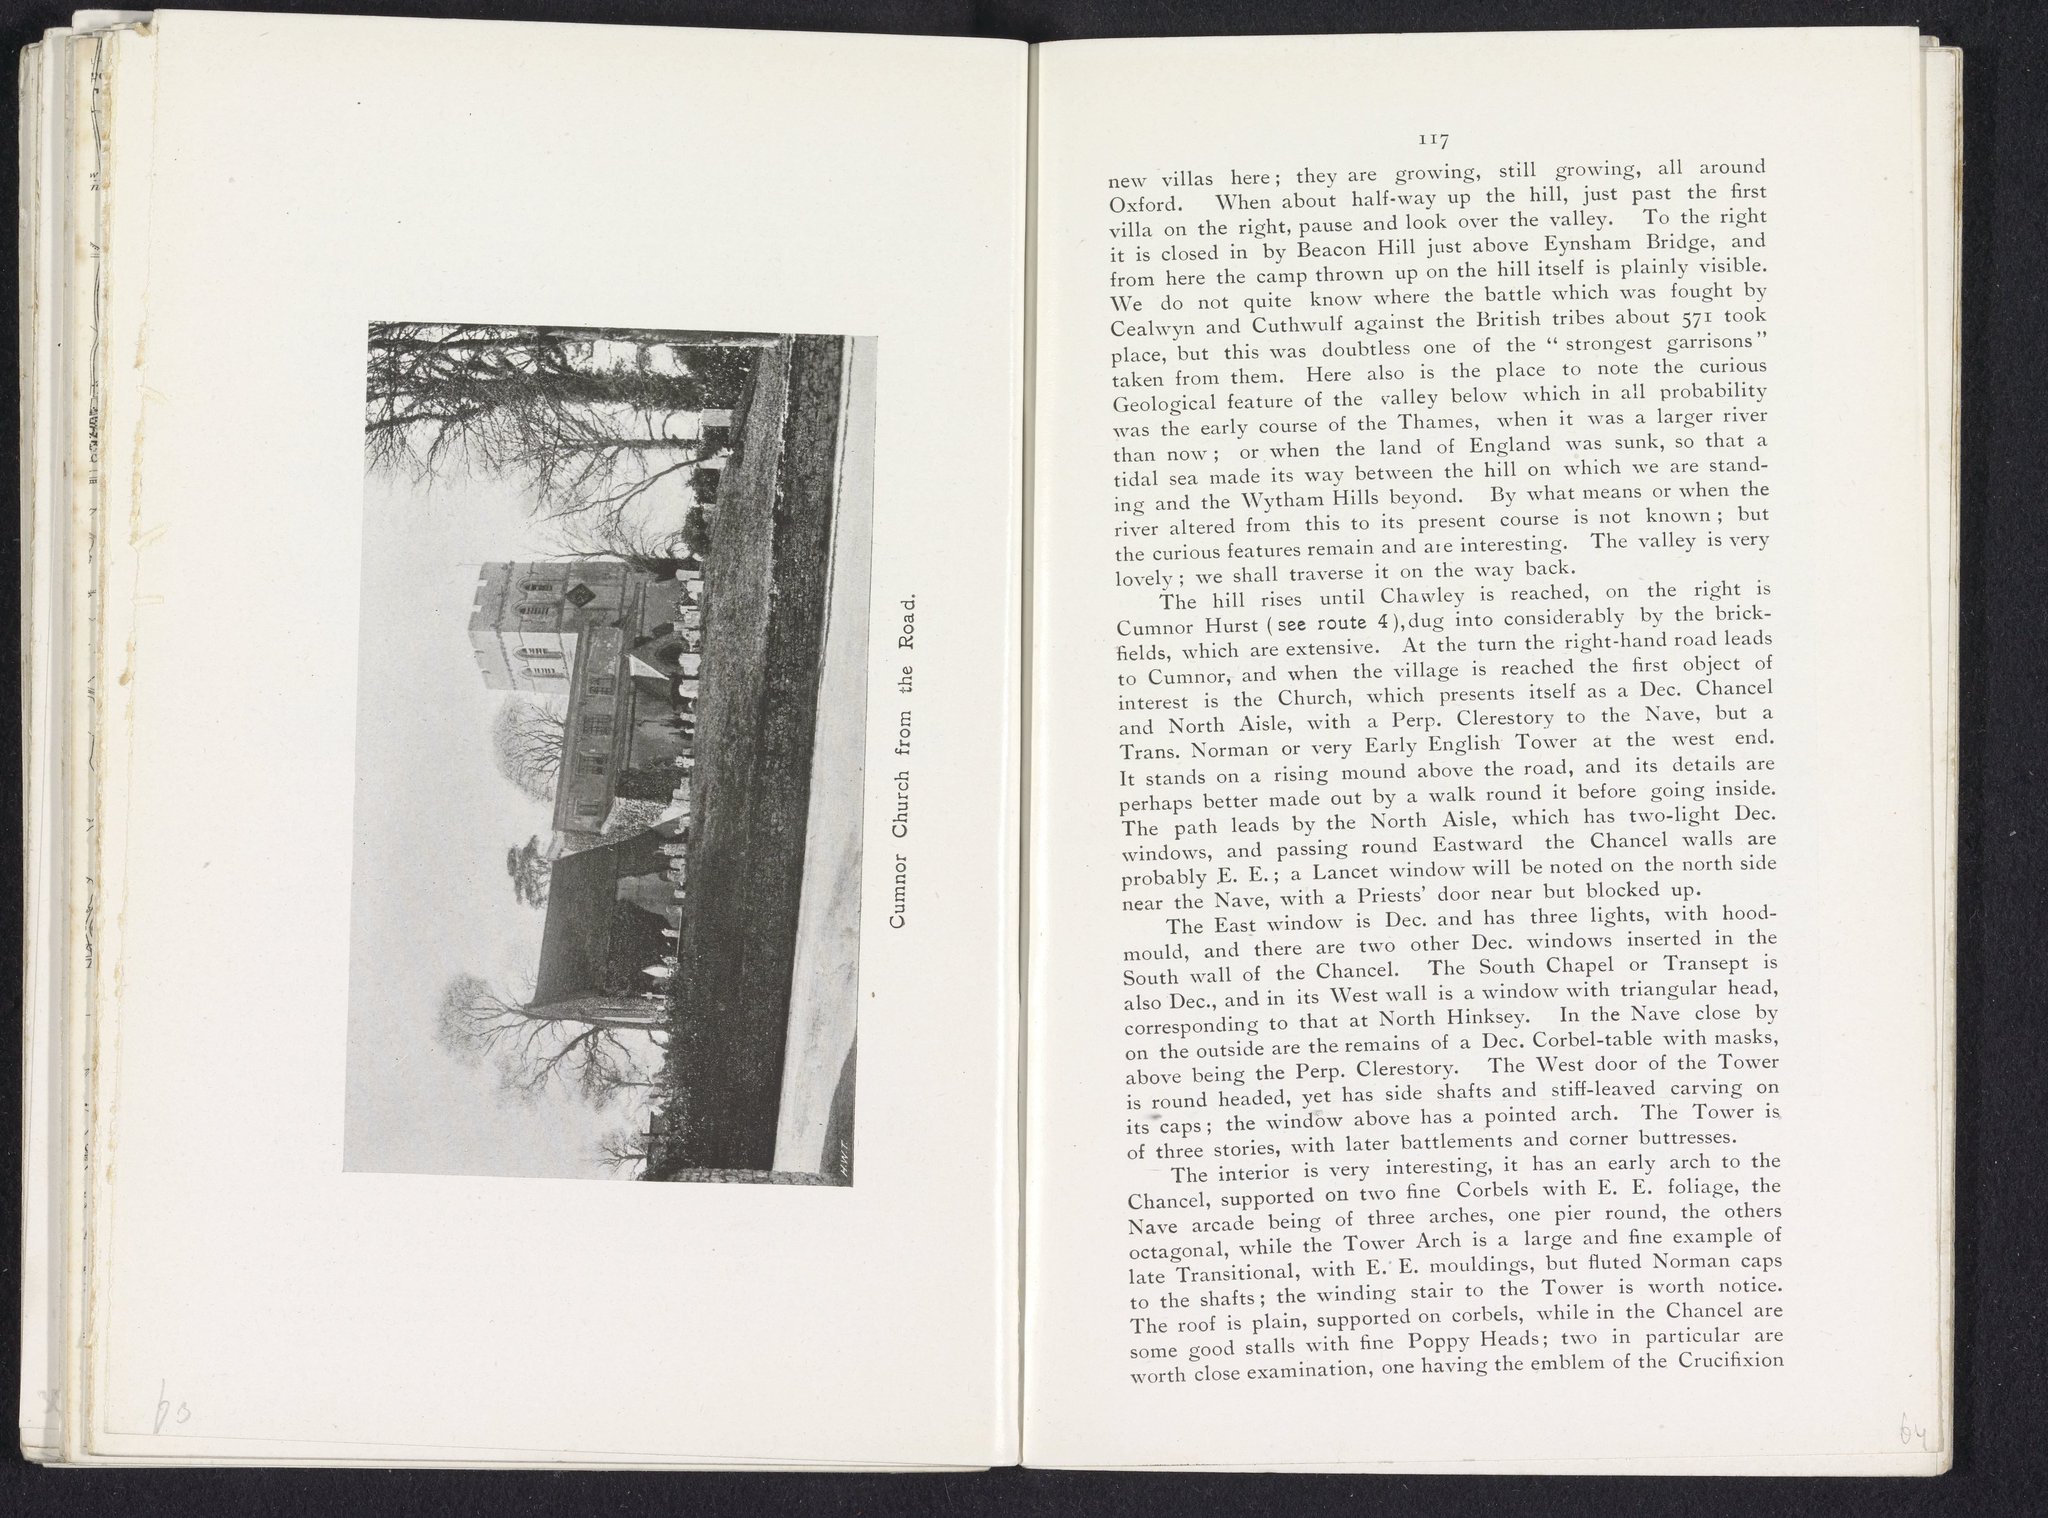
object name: photomechanical print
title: Cumnor Church from the road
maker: henry w. taunt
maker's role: fotograaf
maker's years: 1842-1922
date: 1907-1912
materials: paper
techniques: autotype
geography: cumnor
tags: church (exterior), façade (of house or building)